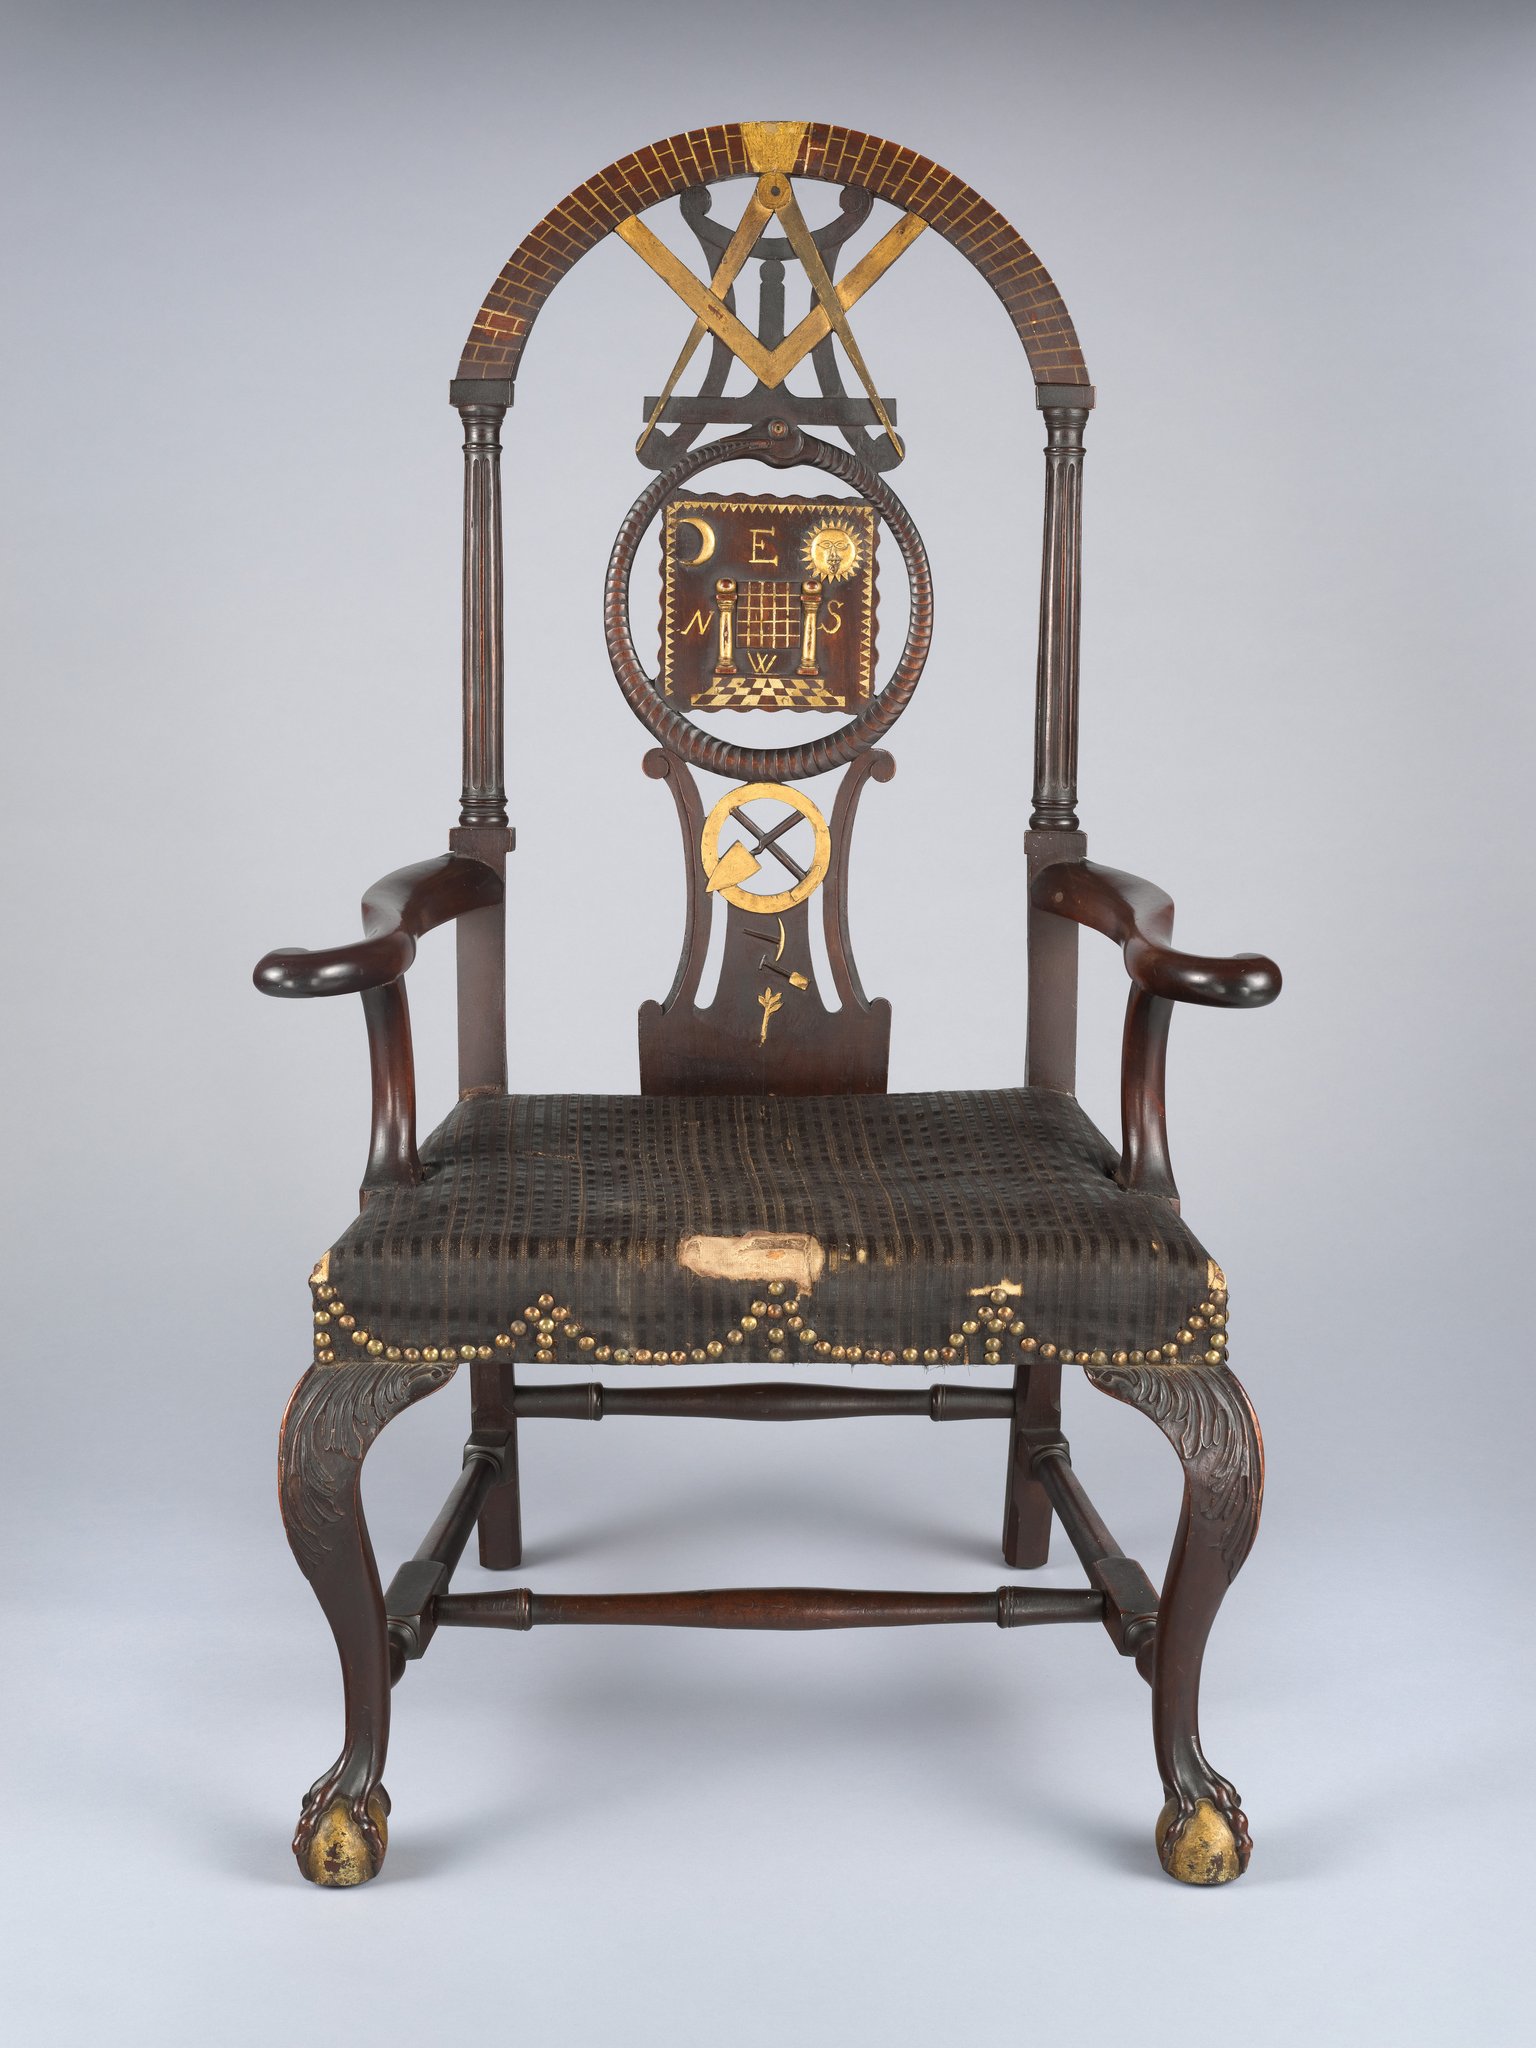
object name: armchair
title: Masonic Armchair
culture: american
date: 1775-1790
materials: hair, linen, wood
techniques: painting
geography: united states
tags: tools